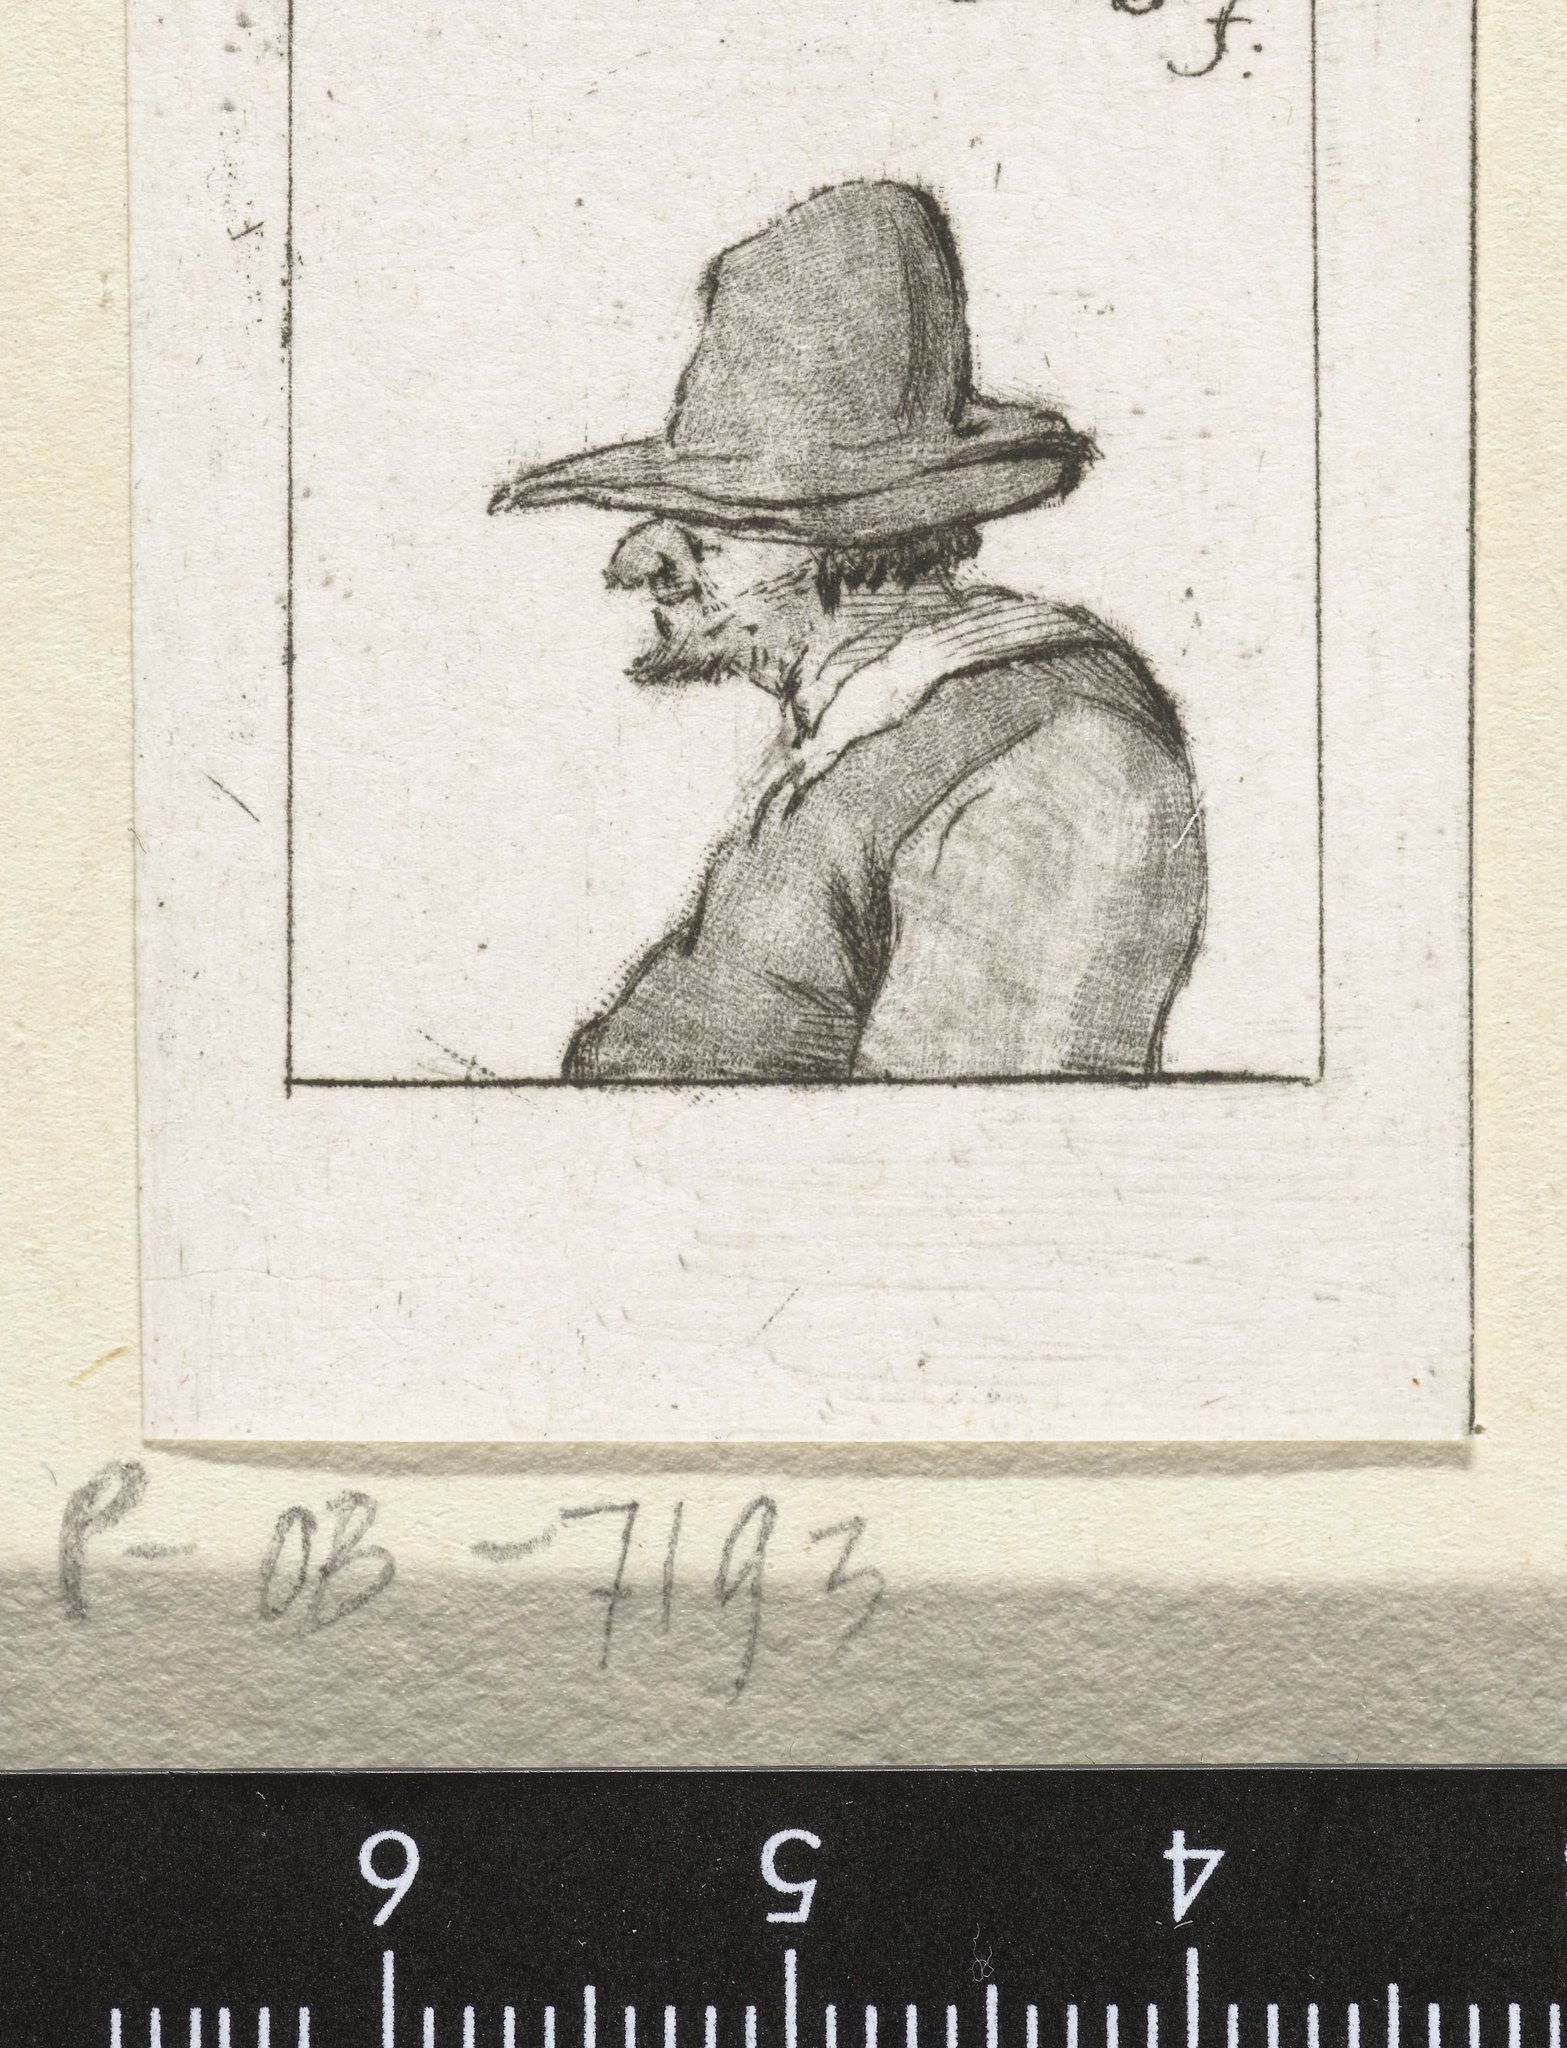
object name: print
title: Buste van een oude boer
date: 1779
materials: paper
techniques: etching, roulette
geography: leiden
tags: farmers, morphology of human expression (+ old male (human being))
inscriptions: collector's mark: Lugt 2228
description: De buste van een oude boer. Buste naar links. Hij draagt een grote hoed.